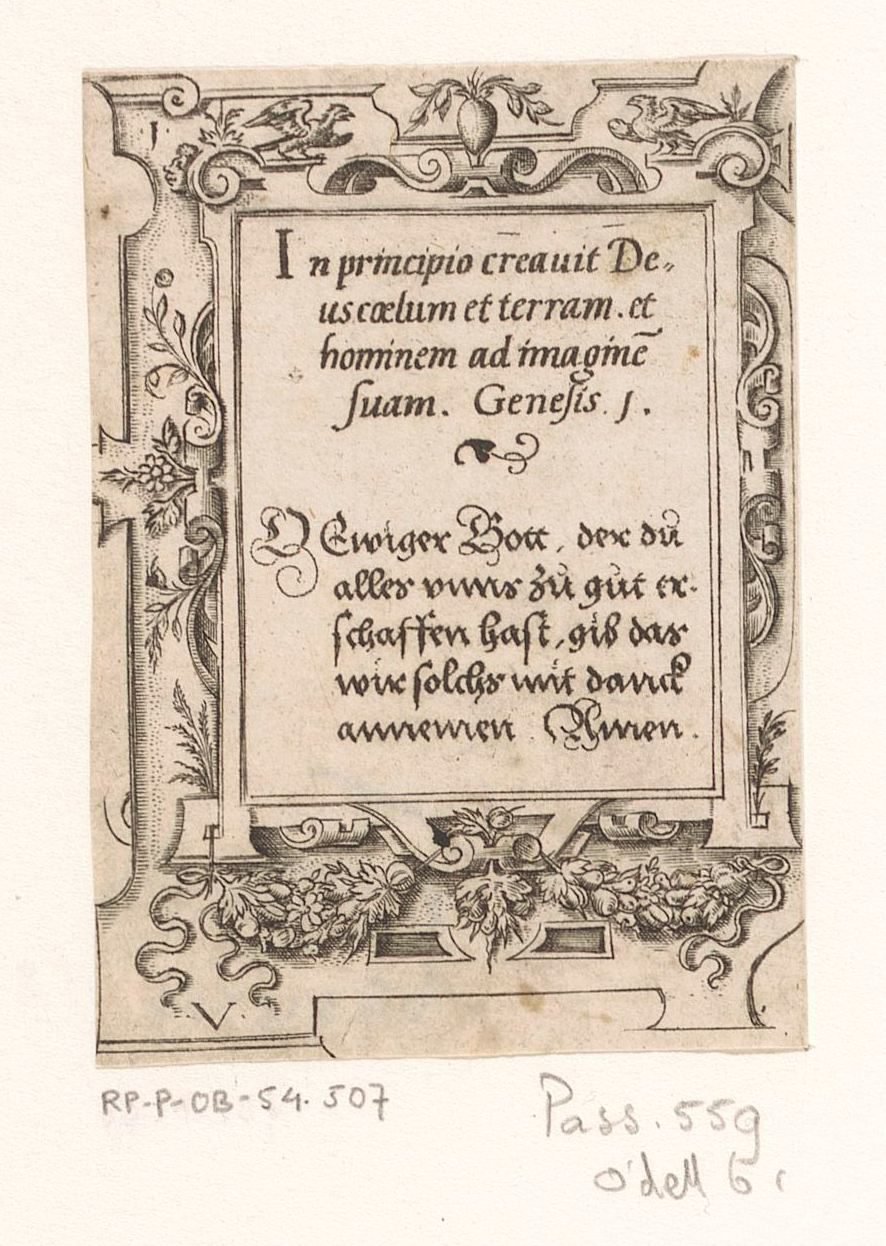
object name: print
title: Gebed in Latijn en Duits in een rolwerk omlijsting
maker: virgilius solis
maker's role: draughtsman, print maker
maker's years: 1514-1562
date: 1568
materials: paper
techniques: engraving, etching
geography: nuremberg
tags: scrollwork, strapwork ~ ornament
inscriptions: collector's mark: Lugt 2228, collector's mark: Lugt 240, number: ‘86’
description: Prent gebruikt voor het gebedenboek: Solis, Virgil. Ein New Künstlich Betbüchlein. Neurenberg: Hieronymus Petri, 1568. Bij elke prent met een Bijbelse scène behoort een genummerde prent met een gebed in het Latijn en in het Duits. Het monogram VS is steeds verspreid over twee bij elkaar horende prenten.